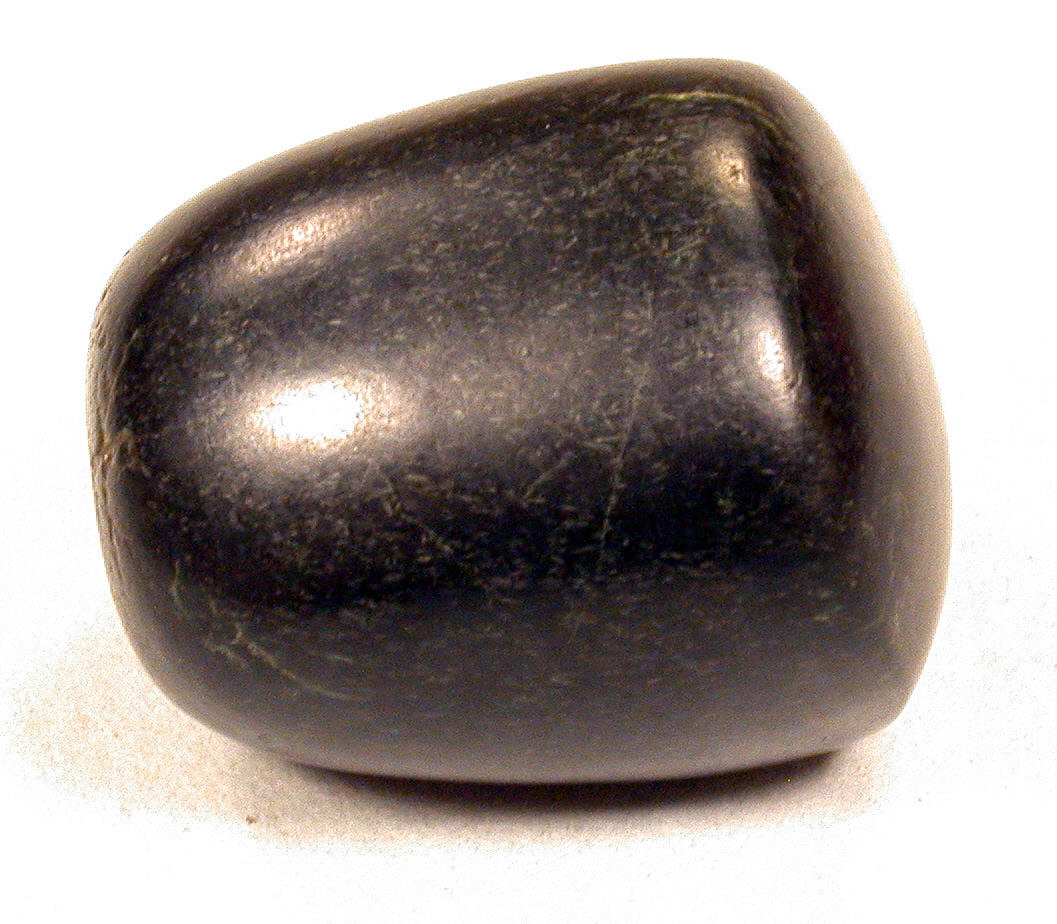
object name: ritual stone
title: Pulidor (polishing stone)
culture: mexican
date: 1501-1600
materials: stone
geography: mexico